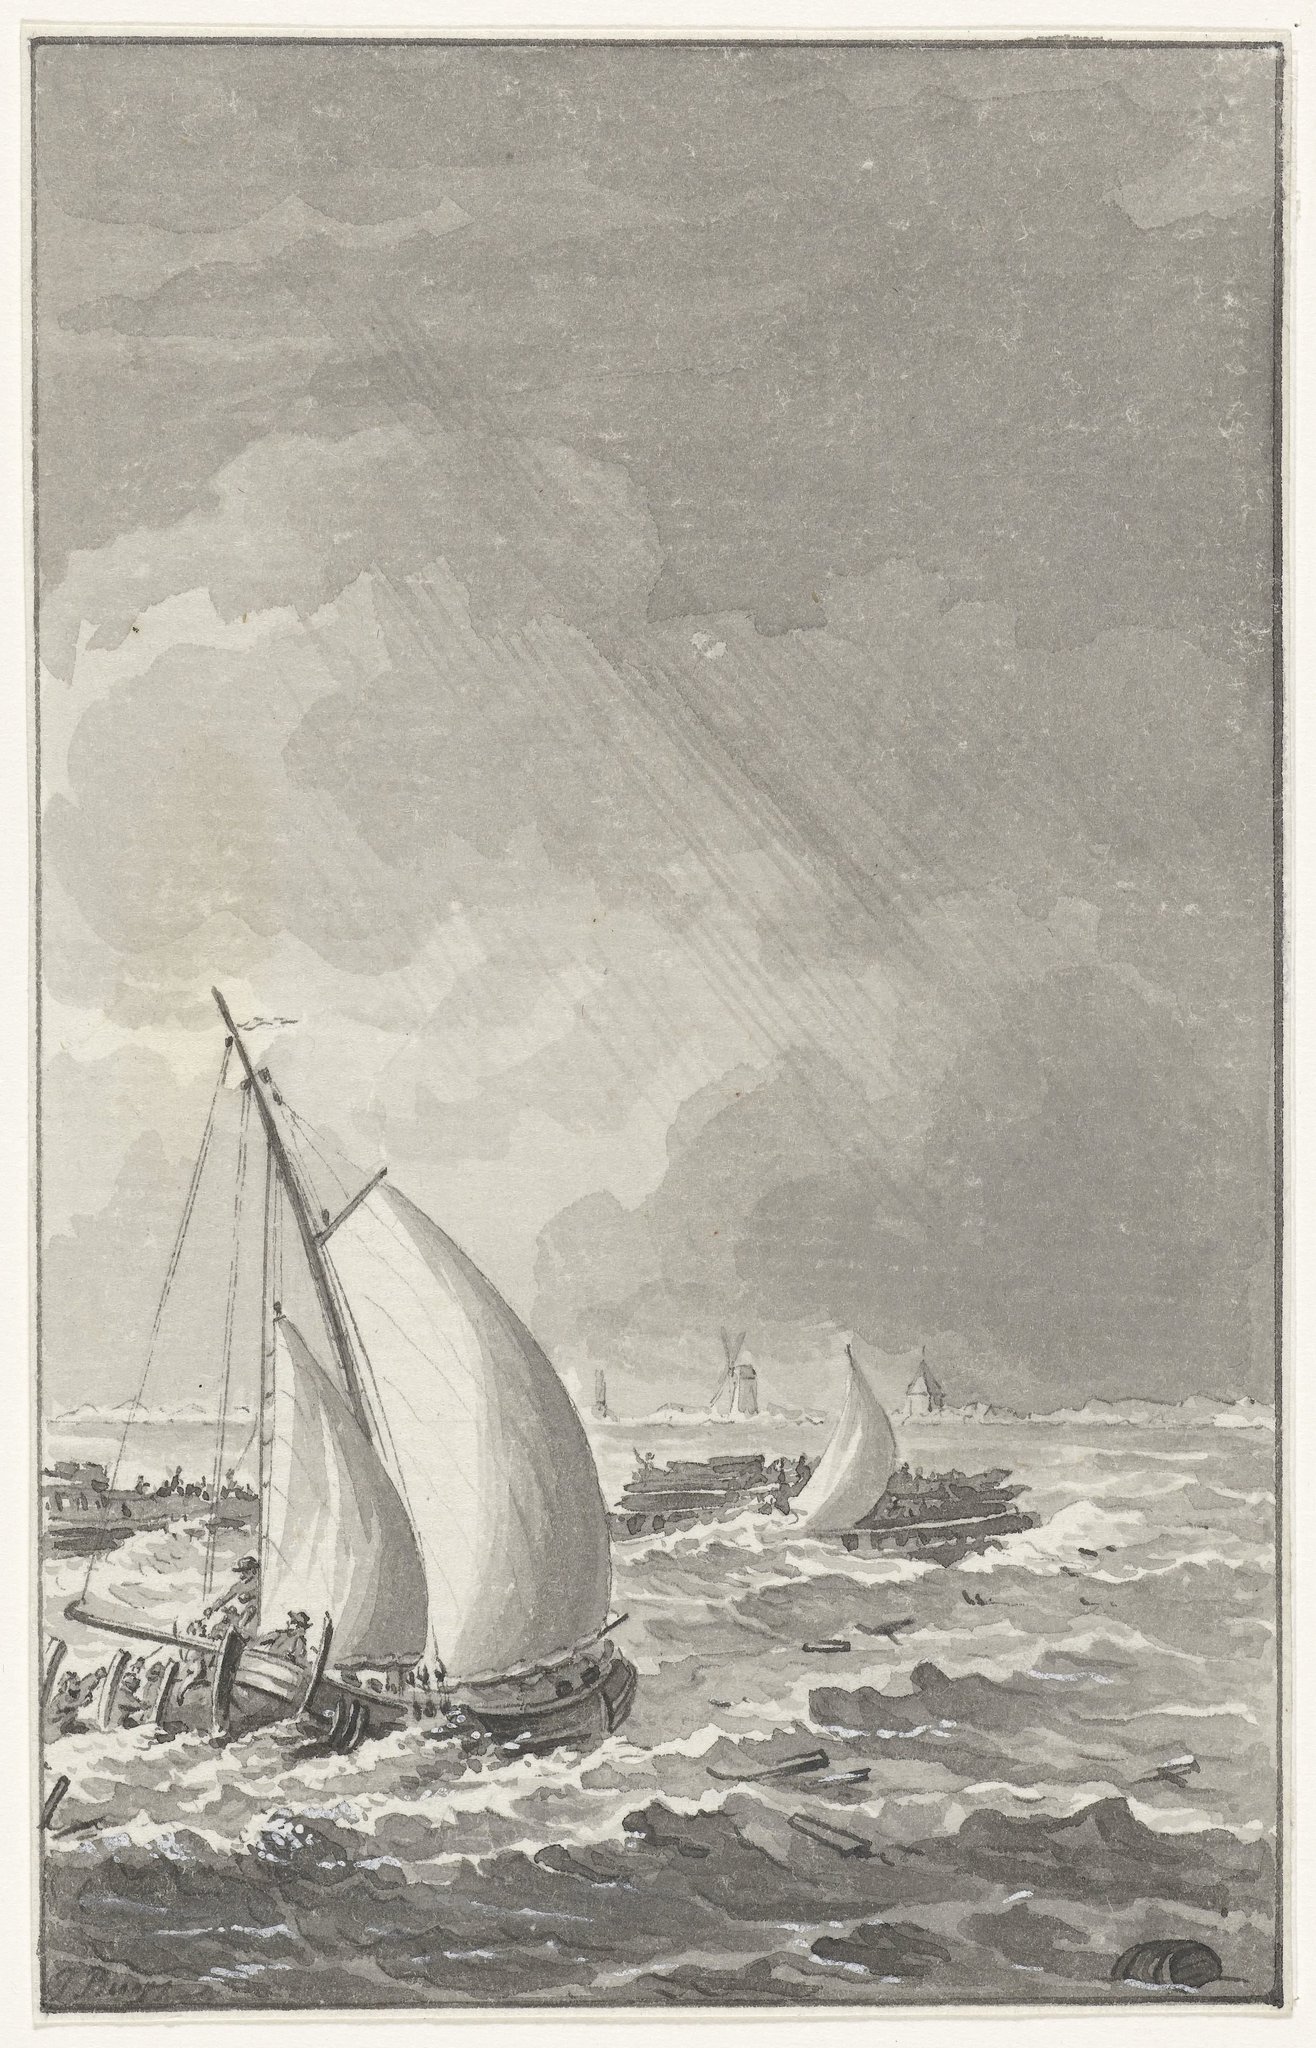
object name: design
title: Gebroeders Naerebout redden de opvarenden van de Woestduin, 1779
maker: jacobus buys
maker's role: draughtsman, print maker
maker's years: 1724-1801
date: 1785-1787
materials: paper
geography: northern netherlands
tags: shipwreck (+ saving the victims ~ traffic accident), sailing-ship, sailing-boat, pilot-boat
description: Ontwerptekening voor de illustratie in: P.A. Loosjes. Vaderlandsche historie, vervattende de geschiedenissen, der Vereenigde Nederlanden [...]. Ten onmiddelyken vervolge van Wagenaar's Vaderlandsche historie. Amsterdam: J. Allart.